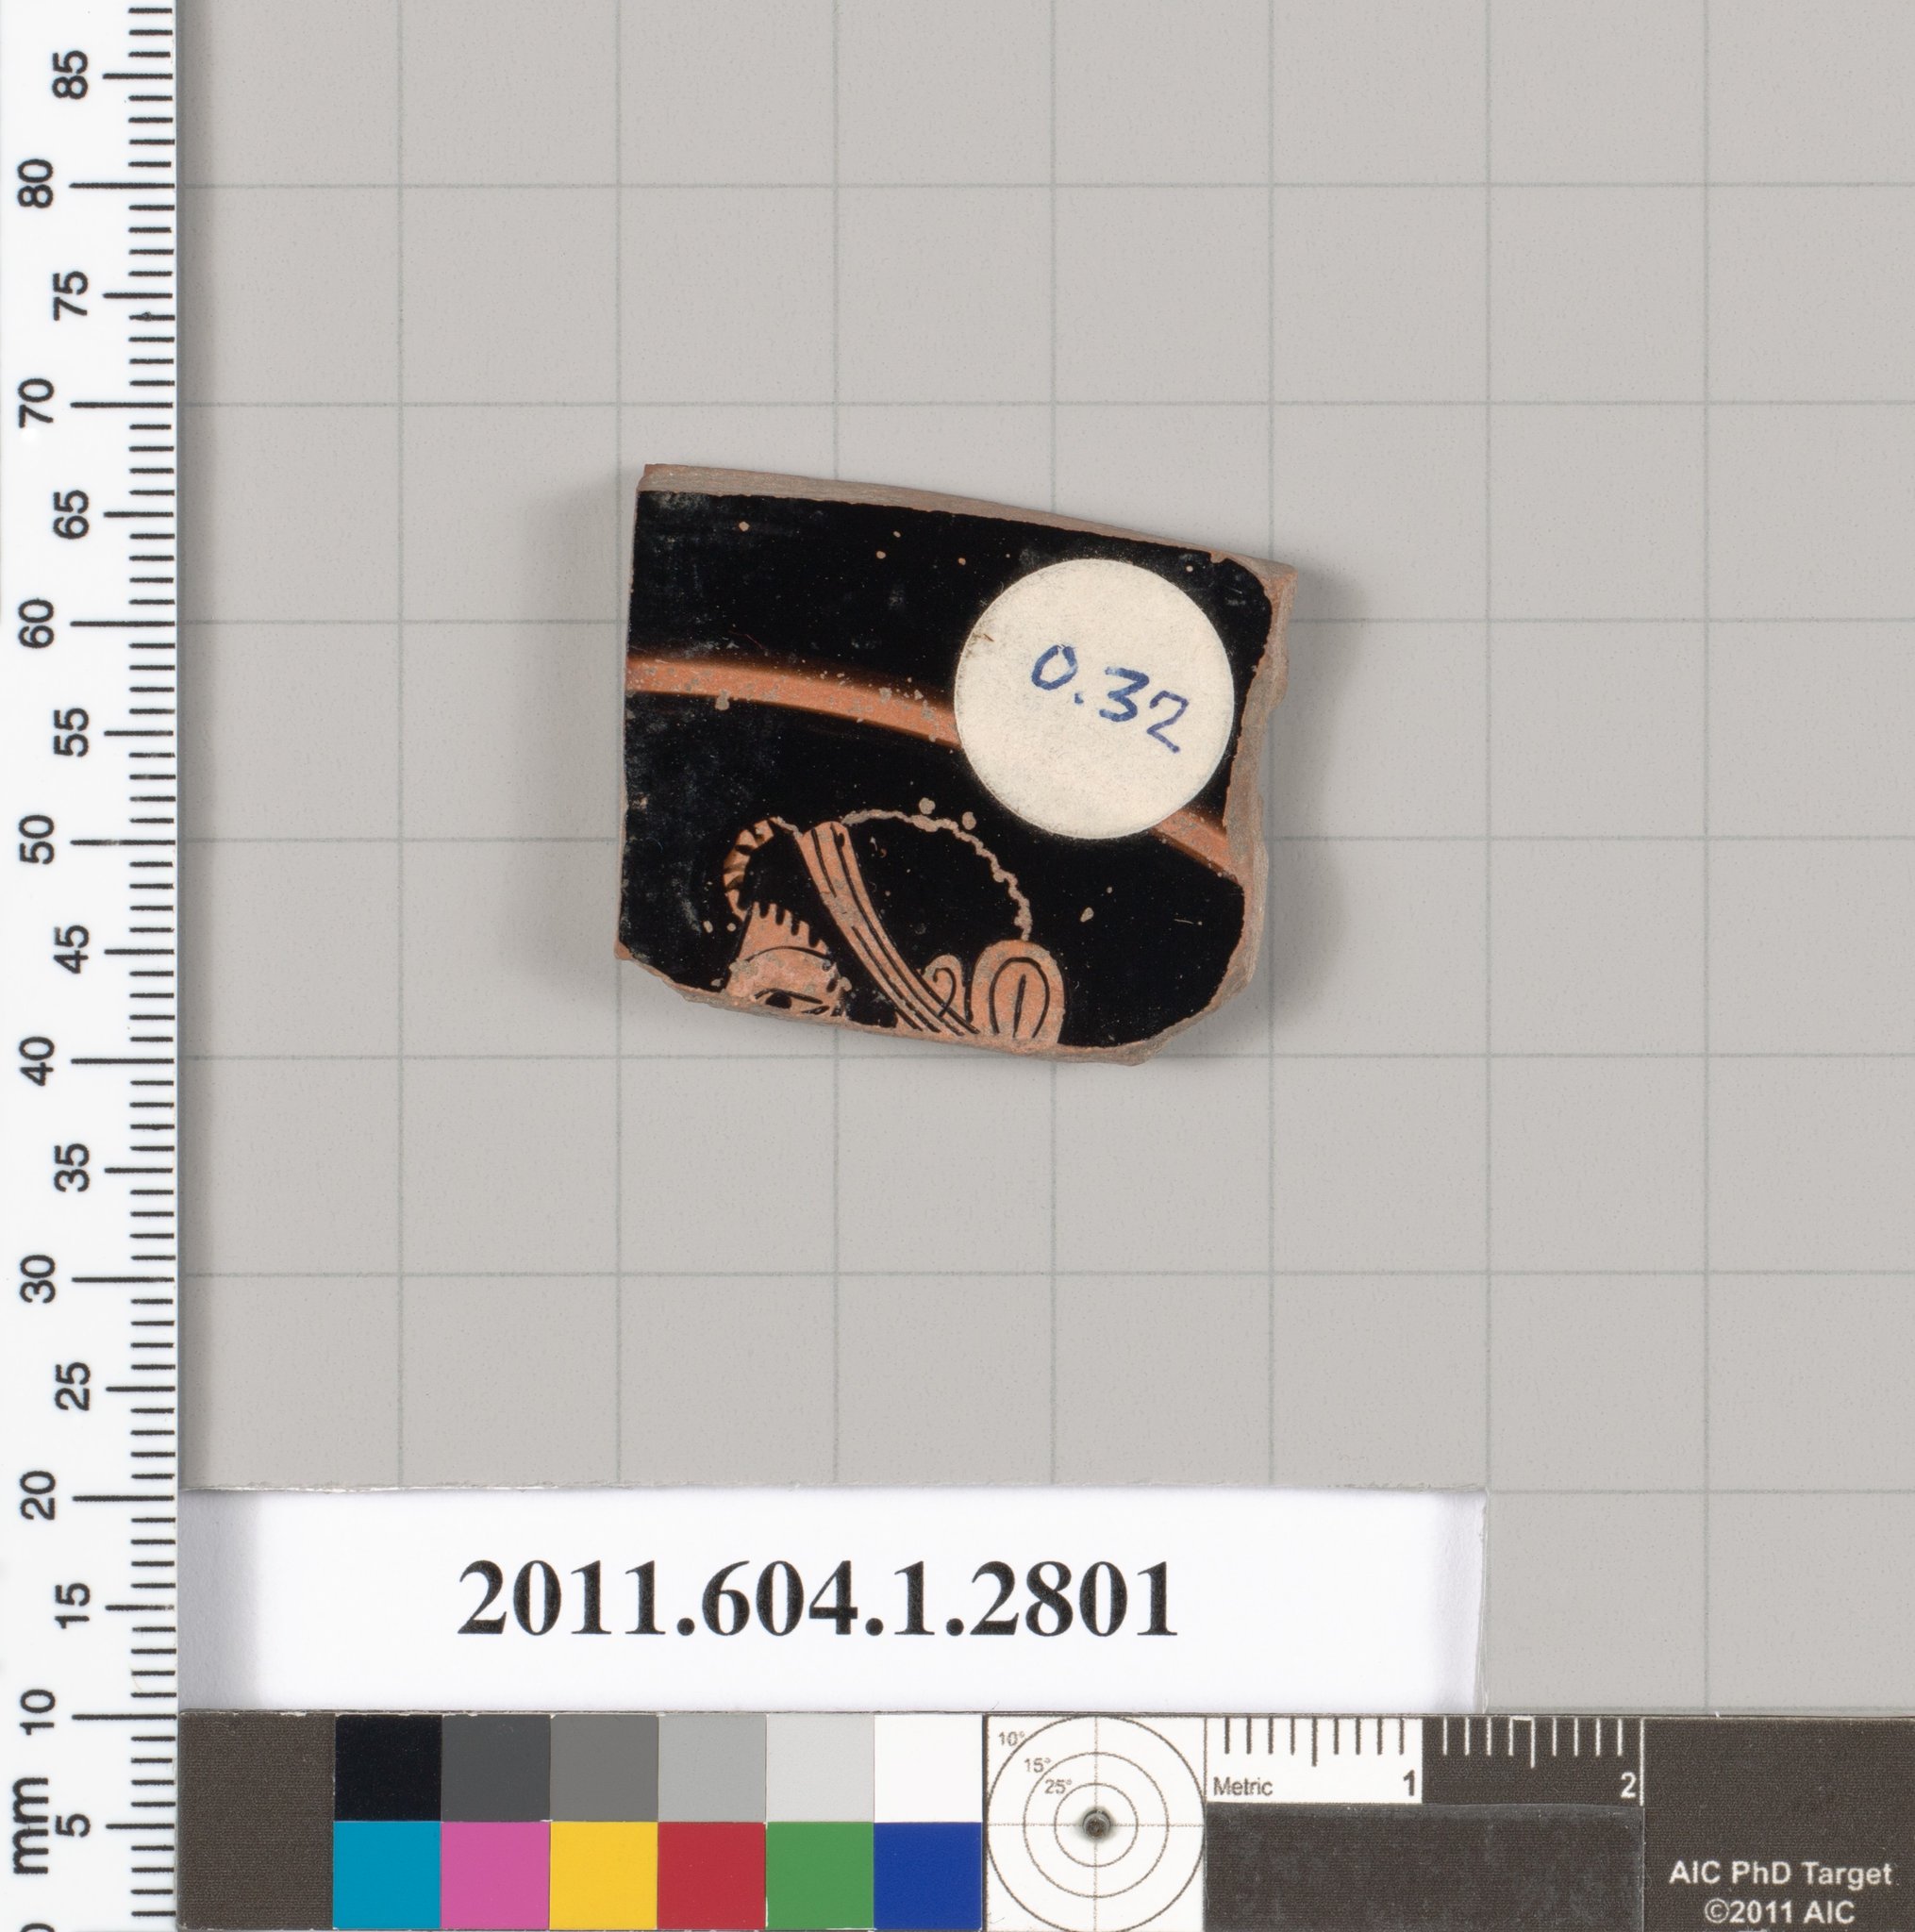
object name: kylix fragment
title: Terracotta fragment of a kylix (drinking cup)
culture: greek, attic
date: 520-500 BCE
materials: terracotta